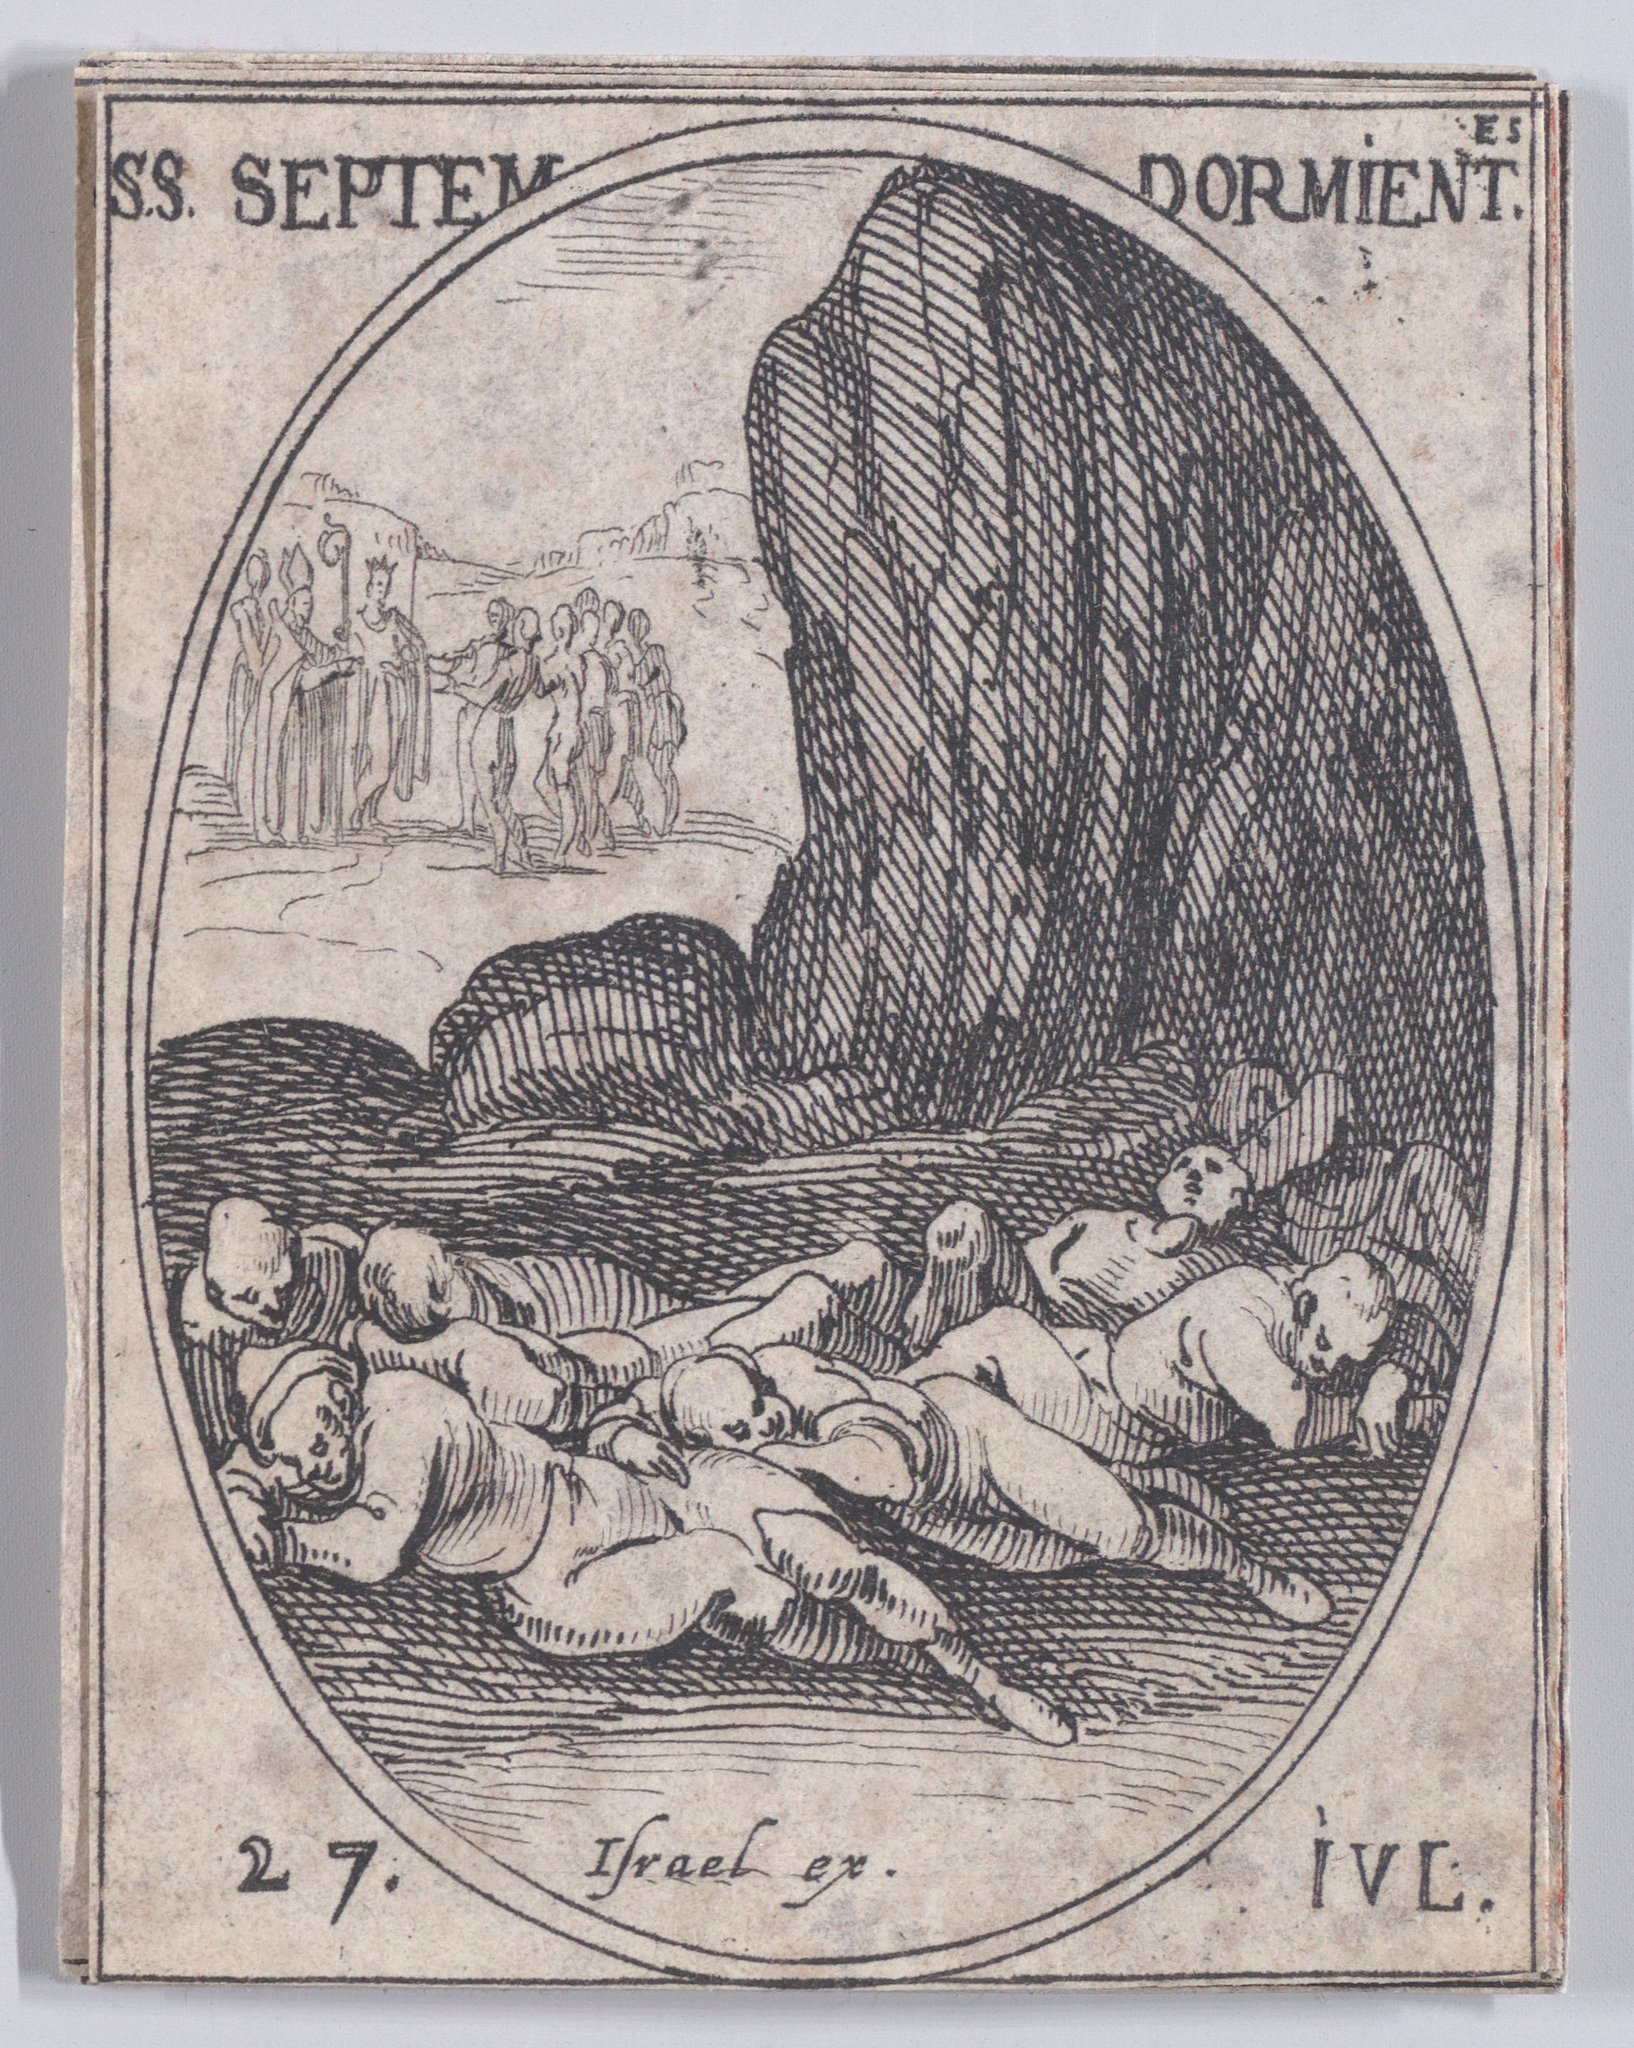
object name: print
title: Les Sept Bienheureux Dormants (The Seven Blessed Sleepers), July 27th, from "Les Images De Tous Les Saincts et Saintes de L'Année" (Images of All of the Saints and Religious Events of the Year)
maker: jacques callot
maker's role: artist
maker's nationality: french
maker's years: 1592-1635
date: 1636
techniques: etching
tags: sleeping,men